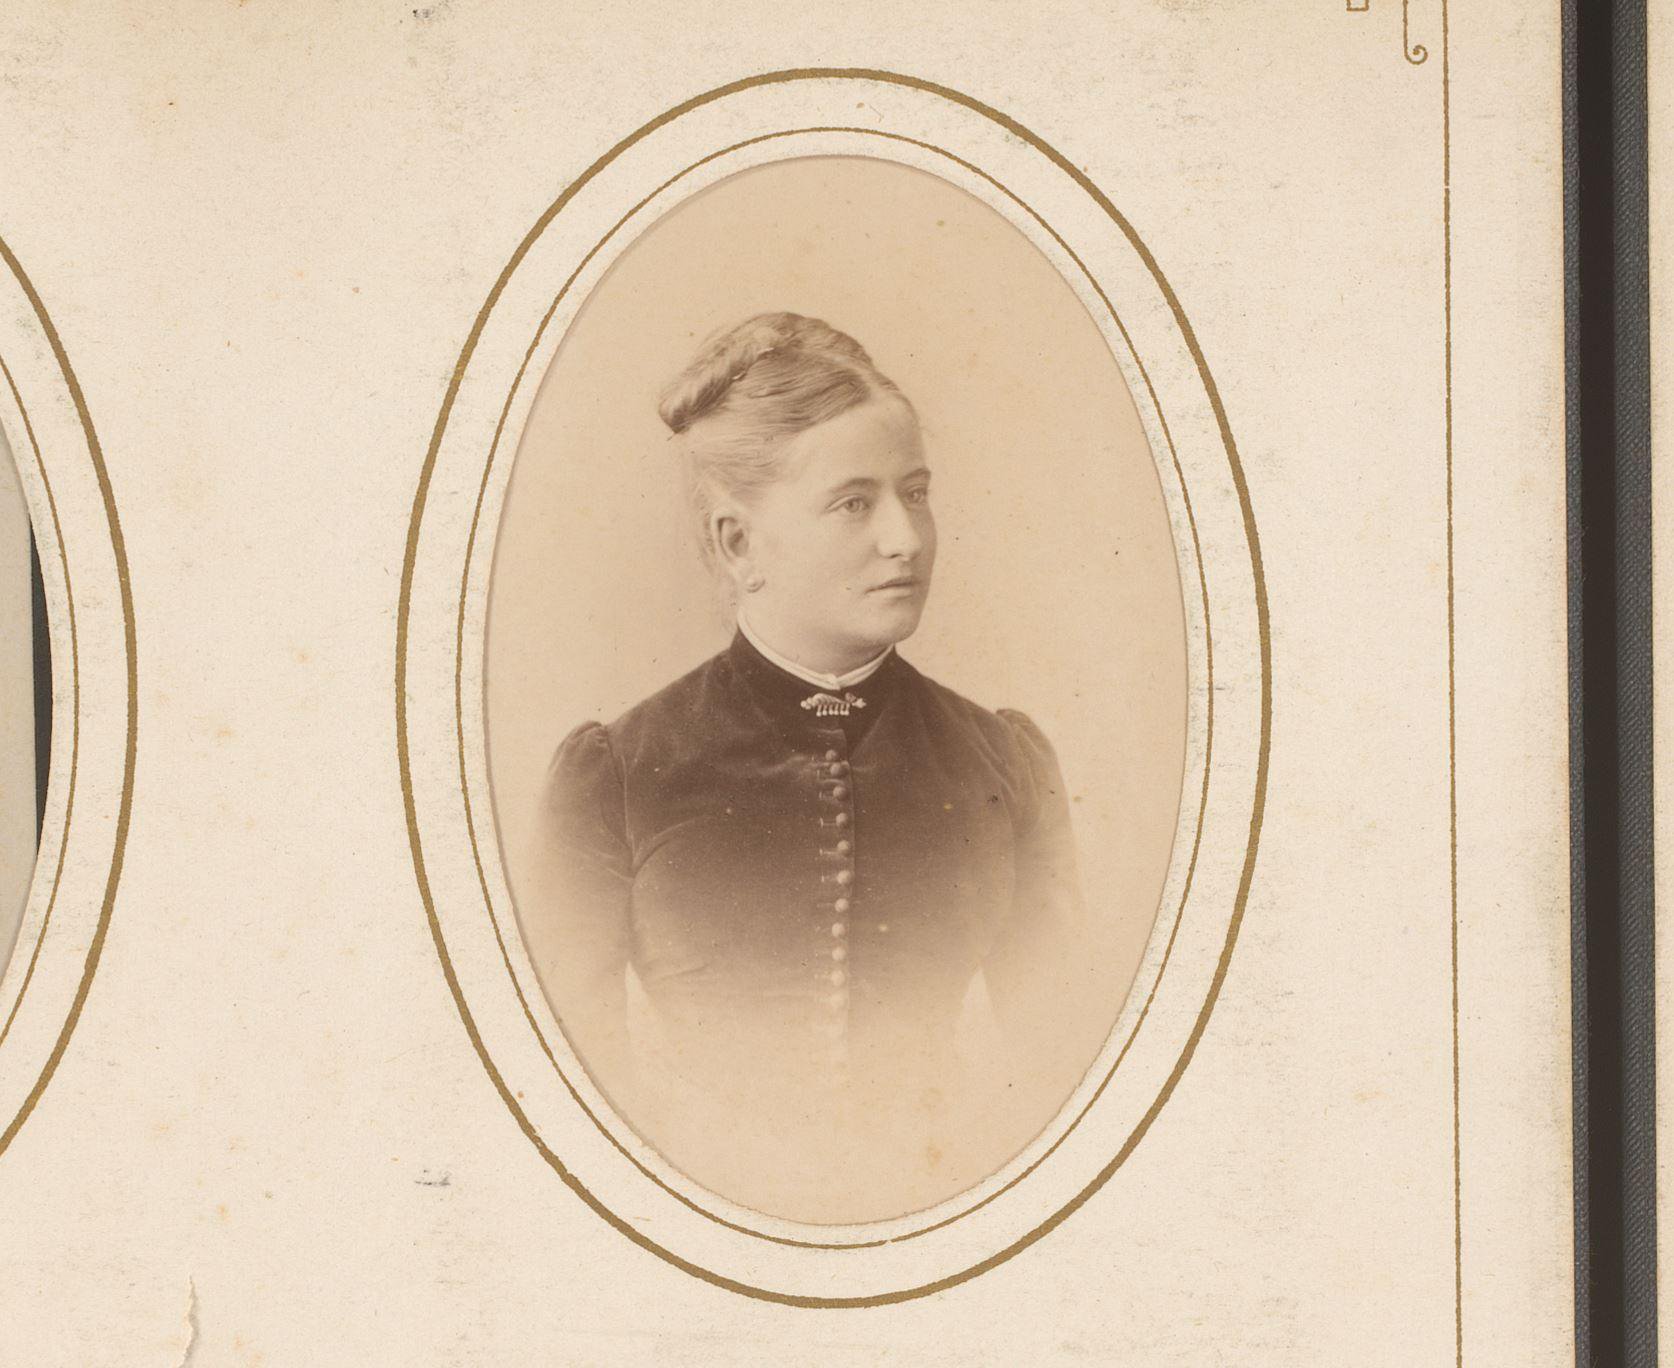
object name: carte de visite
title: Portret van een jonge vrouw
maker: j. ganz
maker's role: fotograaf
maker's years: 1872-1954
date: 1874-1891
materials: cardboard, photographic support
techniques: albumen print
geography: brussels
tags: adolescent, young woman, maiden, historical persons - bb - woman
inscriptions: inscription: ‘(...)/ J. Ganz/ 38, Rue de l'Ecuyer,/ en face des Galeries St. Hubert./ BRUXELLES./ (...)/ Les Clichés sont conservés.’